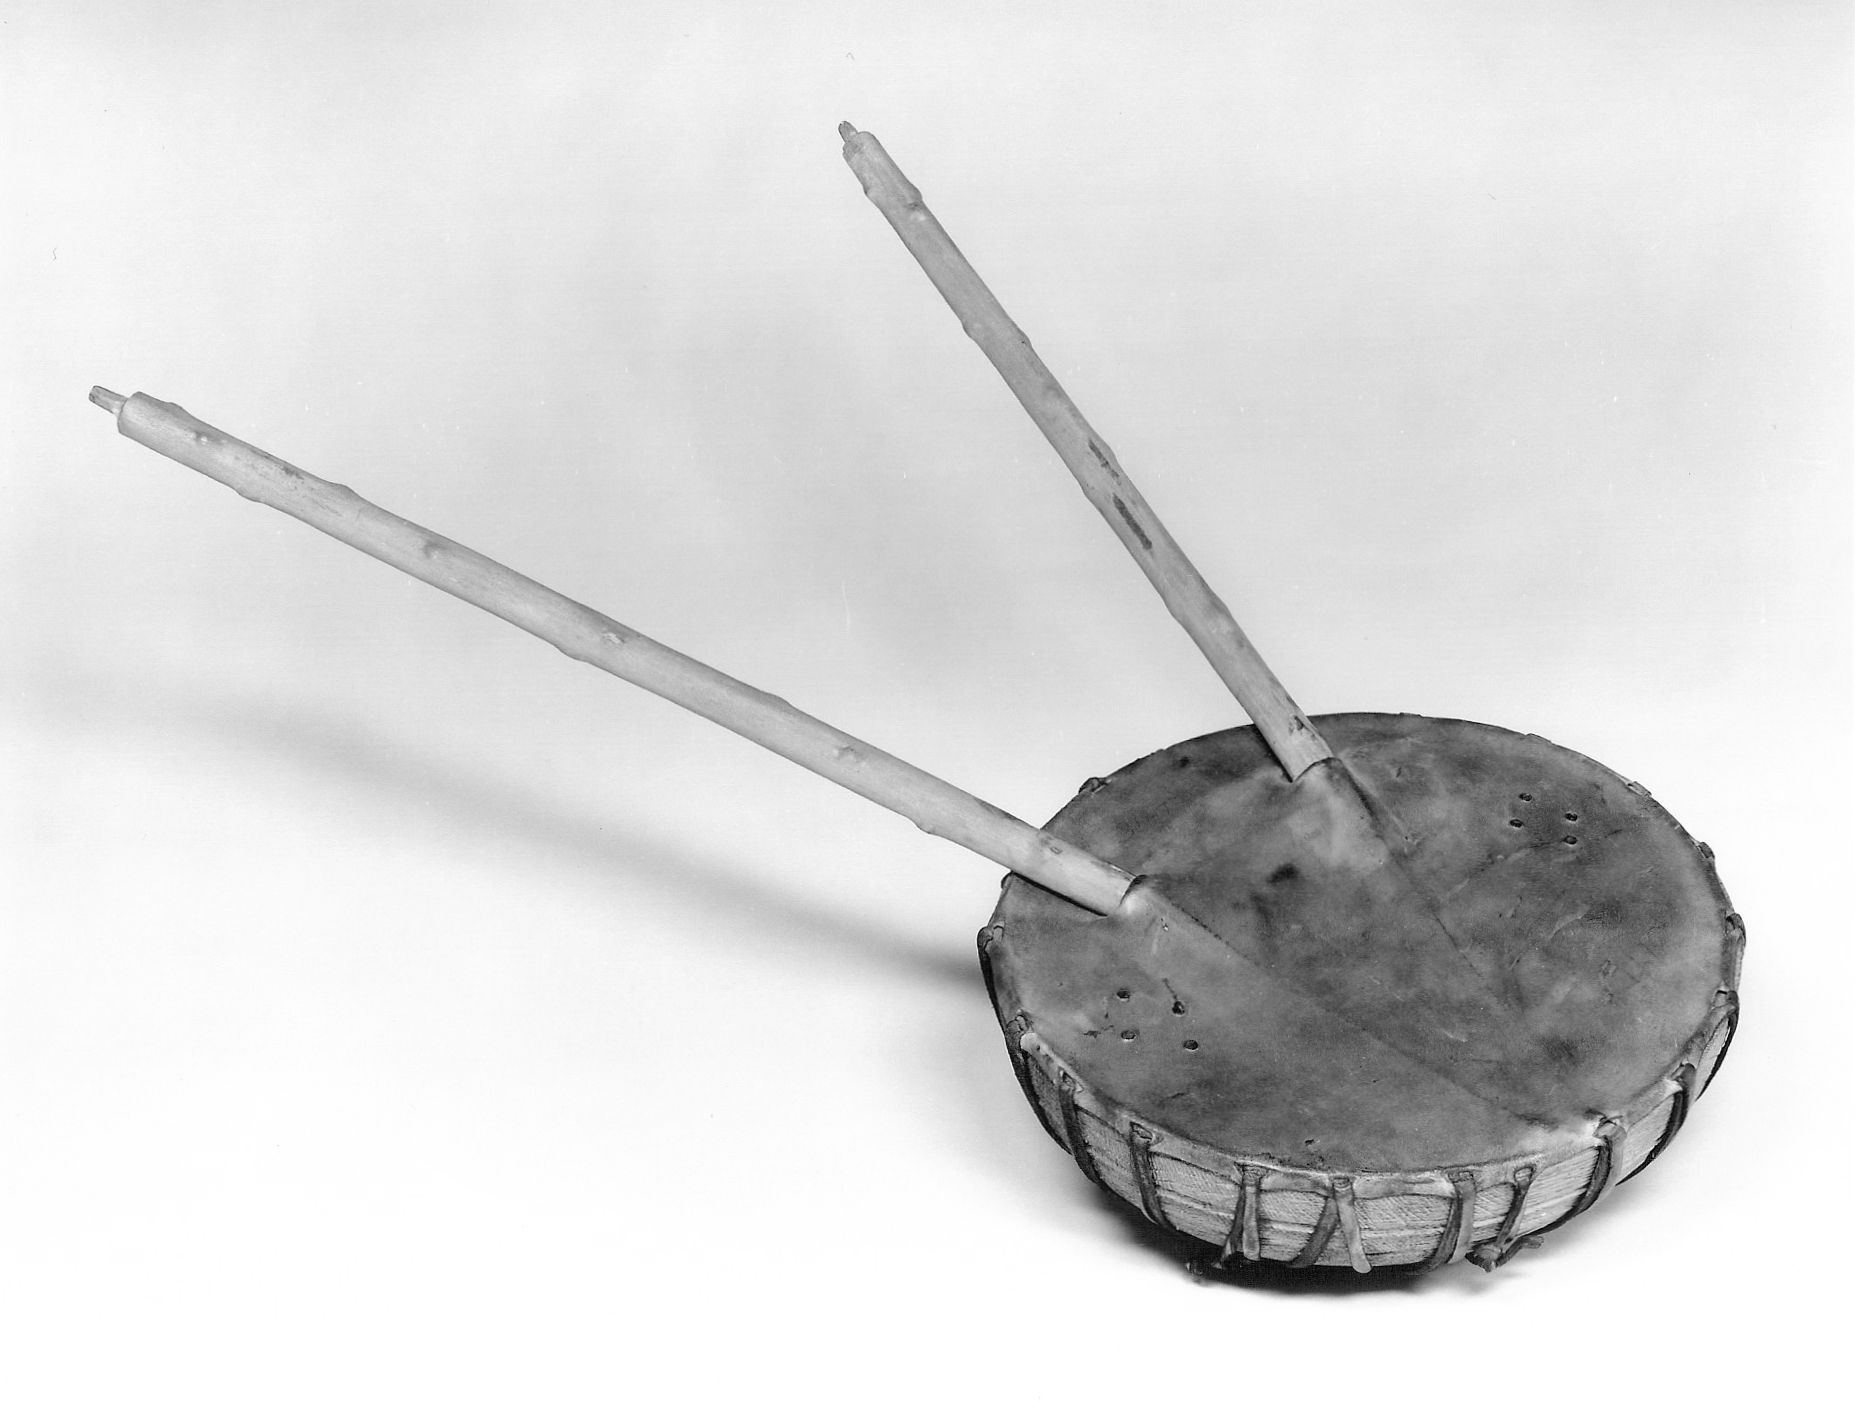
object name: lyre reproduction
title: Lyre (reproduction)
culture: egyptian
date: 1801-1900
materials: wood, skin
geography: egypt